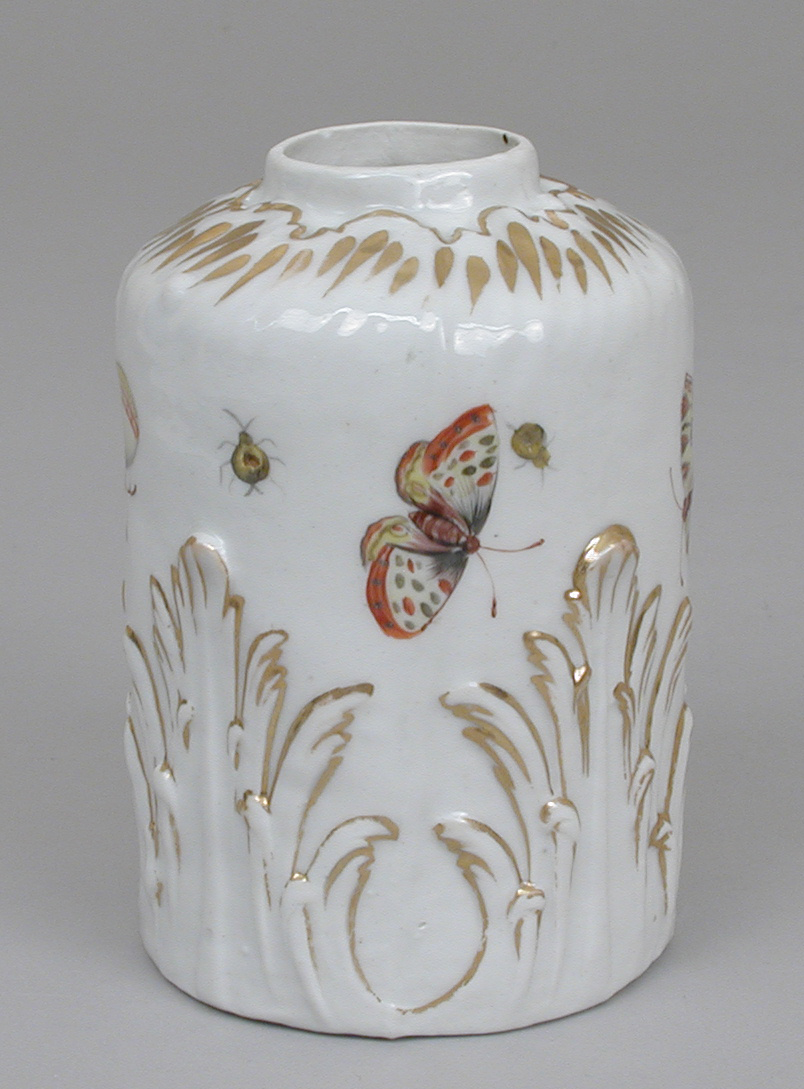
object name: tea caddy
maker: volkstedt porcelain manufactory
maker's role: manufactory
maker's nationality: german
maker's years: 1760-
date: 1767-1800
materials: hard paste porcelain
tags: insects,butterflies